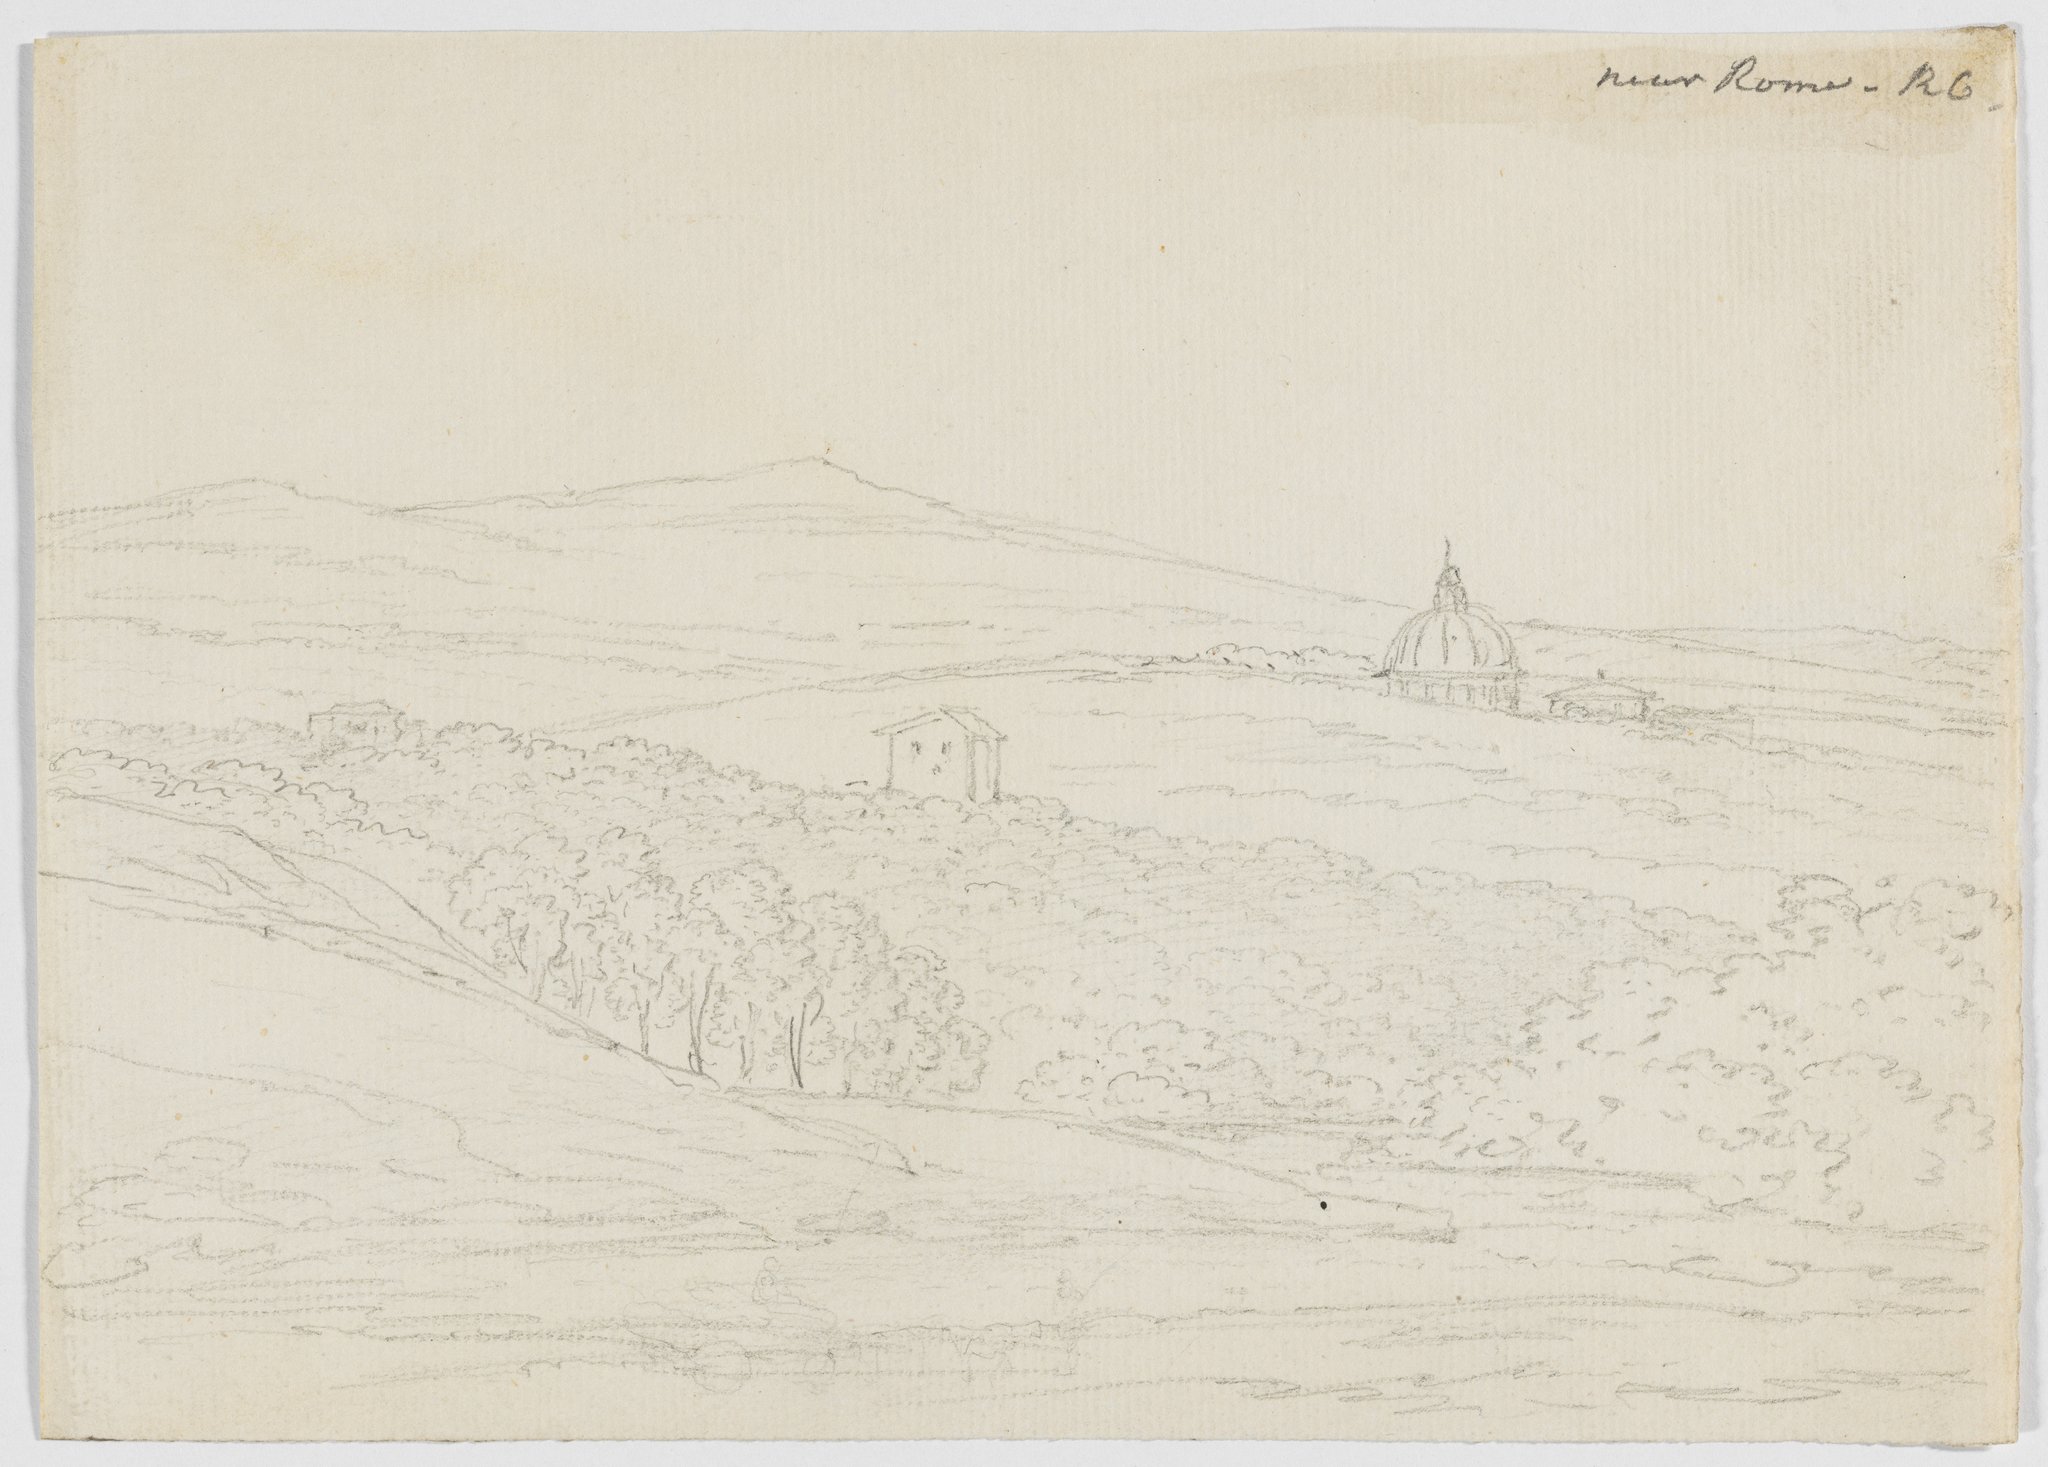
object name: drawing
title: Near Rome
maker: richard cooper ii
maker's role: artist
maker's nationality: british, scottish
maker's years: 1740-1822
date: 1774-1775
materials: graphite